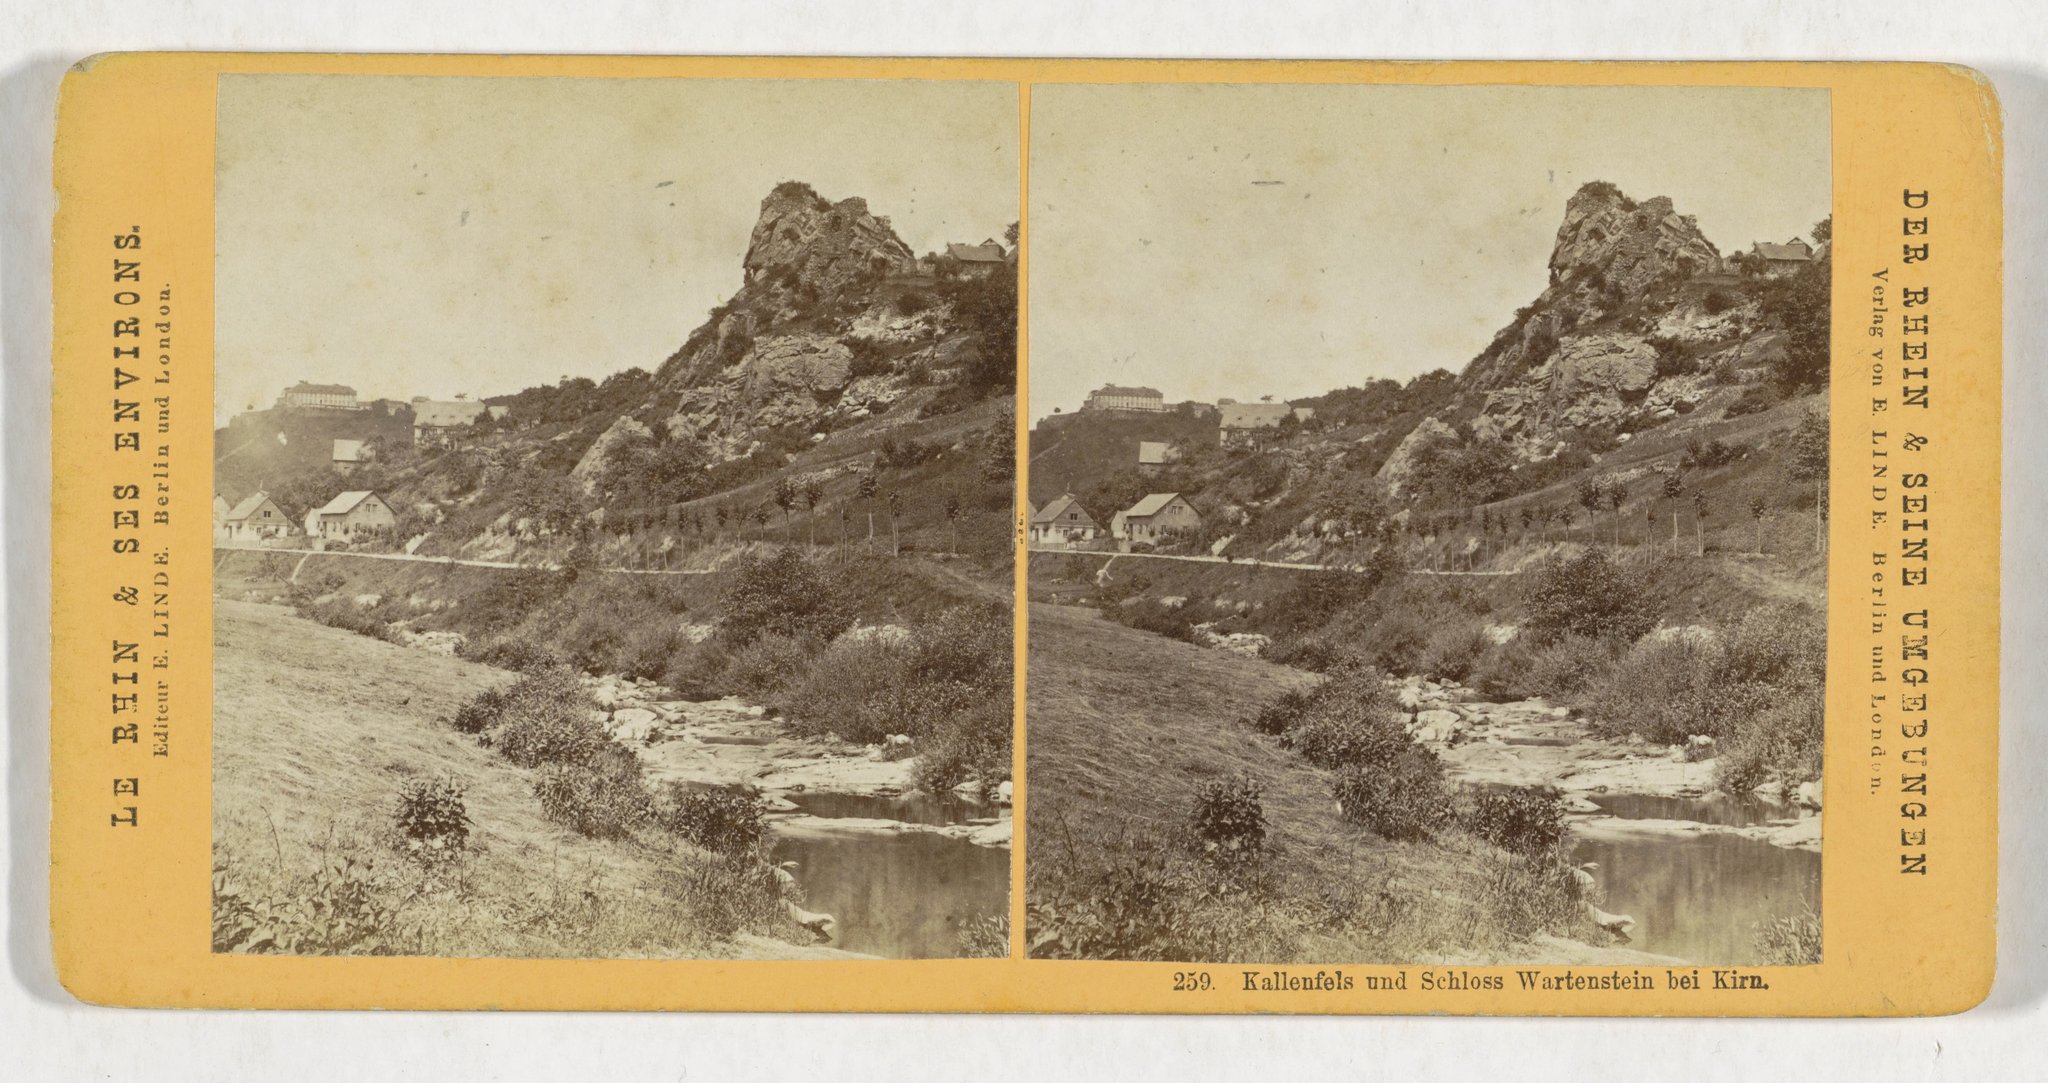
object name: stereograph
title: Gezicht op Kallenfels en slot Wartenstein, nabij Kirn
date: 1868-1890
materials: cardboard, paper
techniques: albumen print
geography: kallenfels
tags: rock-formations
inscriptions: number: ‘259.’